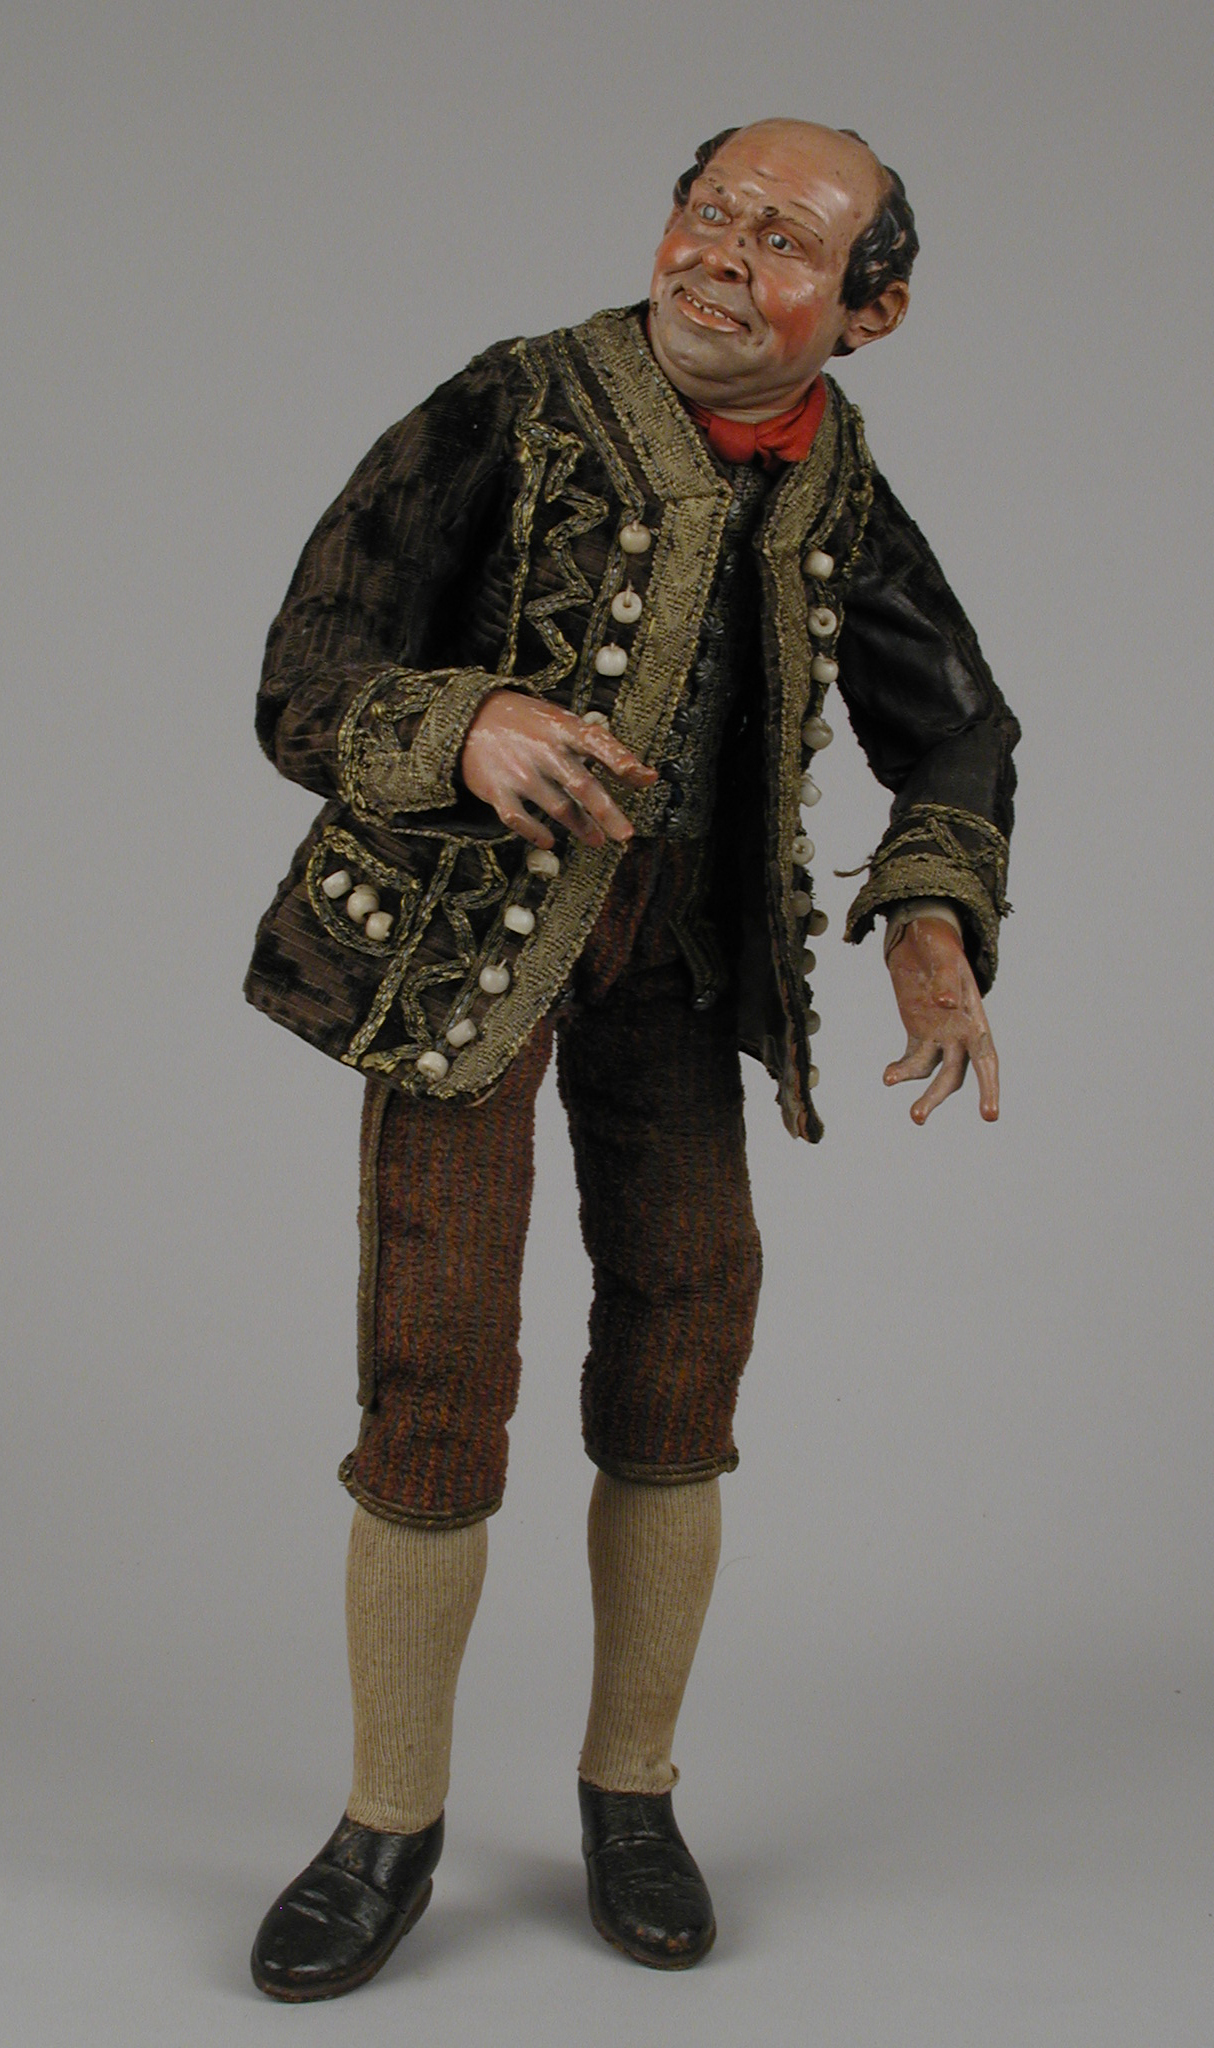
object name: crèche figure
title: Man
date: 1801-1900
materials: terracotta, wood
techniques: polychrome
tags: men